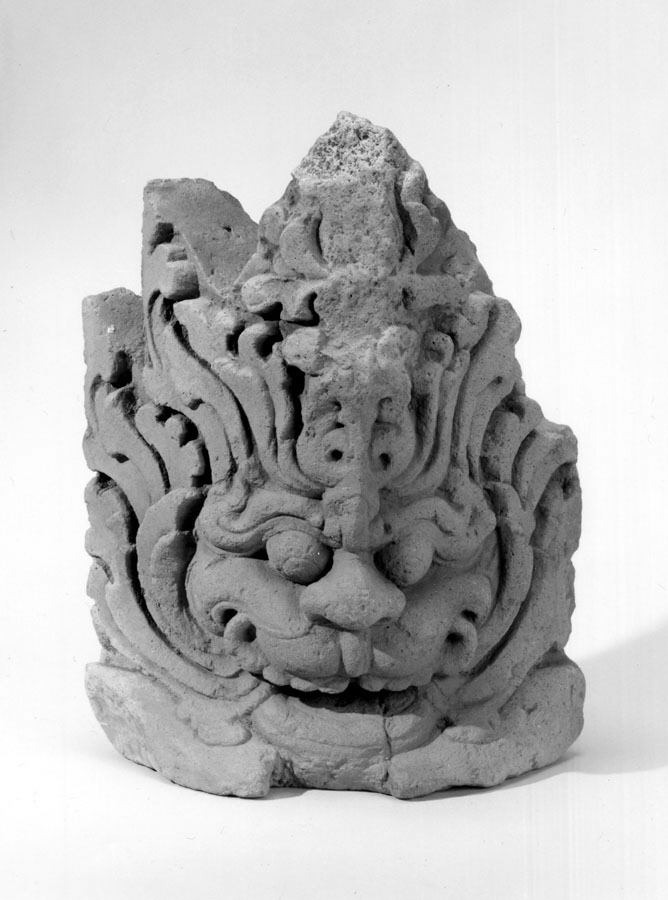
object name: antefix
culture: indonesian, javanese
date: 801-900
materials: terracotta